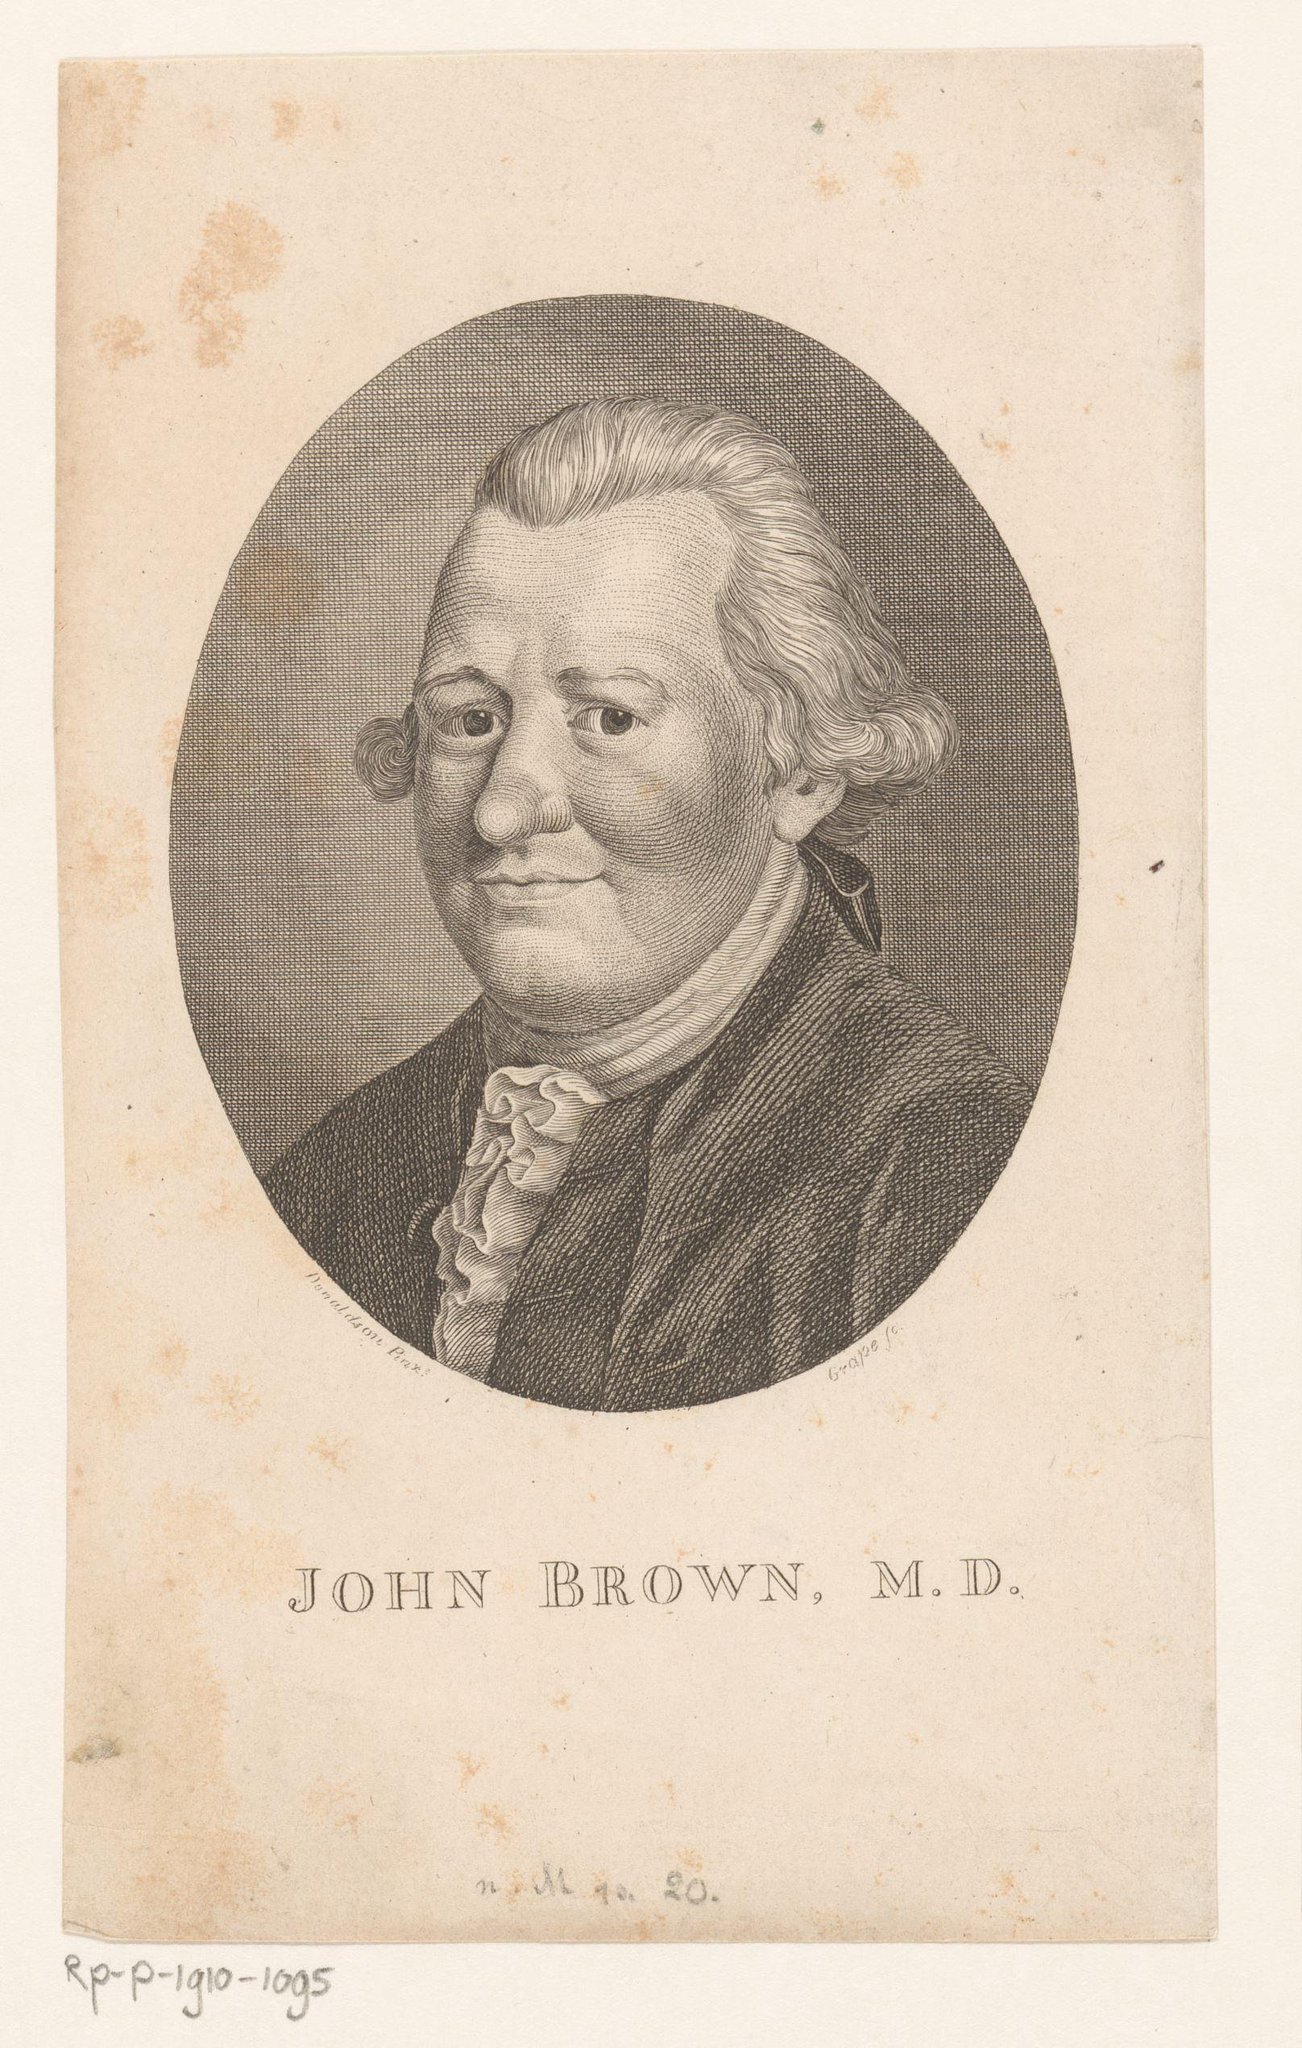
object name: print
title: Portret van John Brown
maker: john donaldson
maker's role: painter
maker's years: 1737-1801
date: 1771-1788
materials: paper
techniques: engraving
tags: historical persons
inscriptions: collector's mark: Lugt 2228